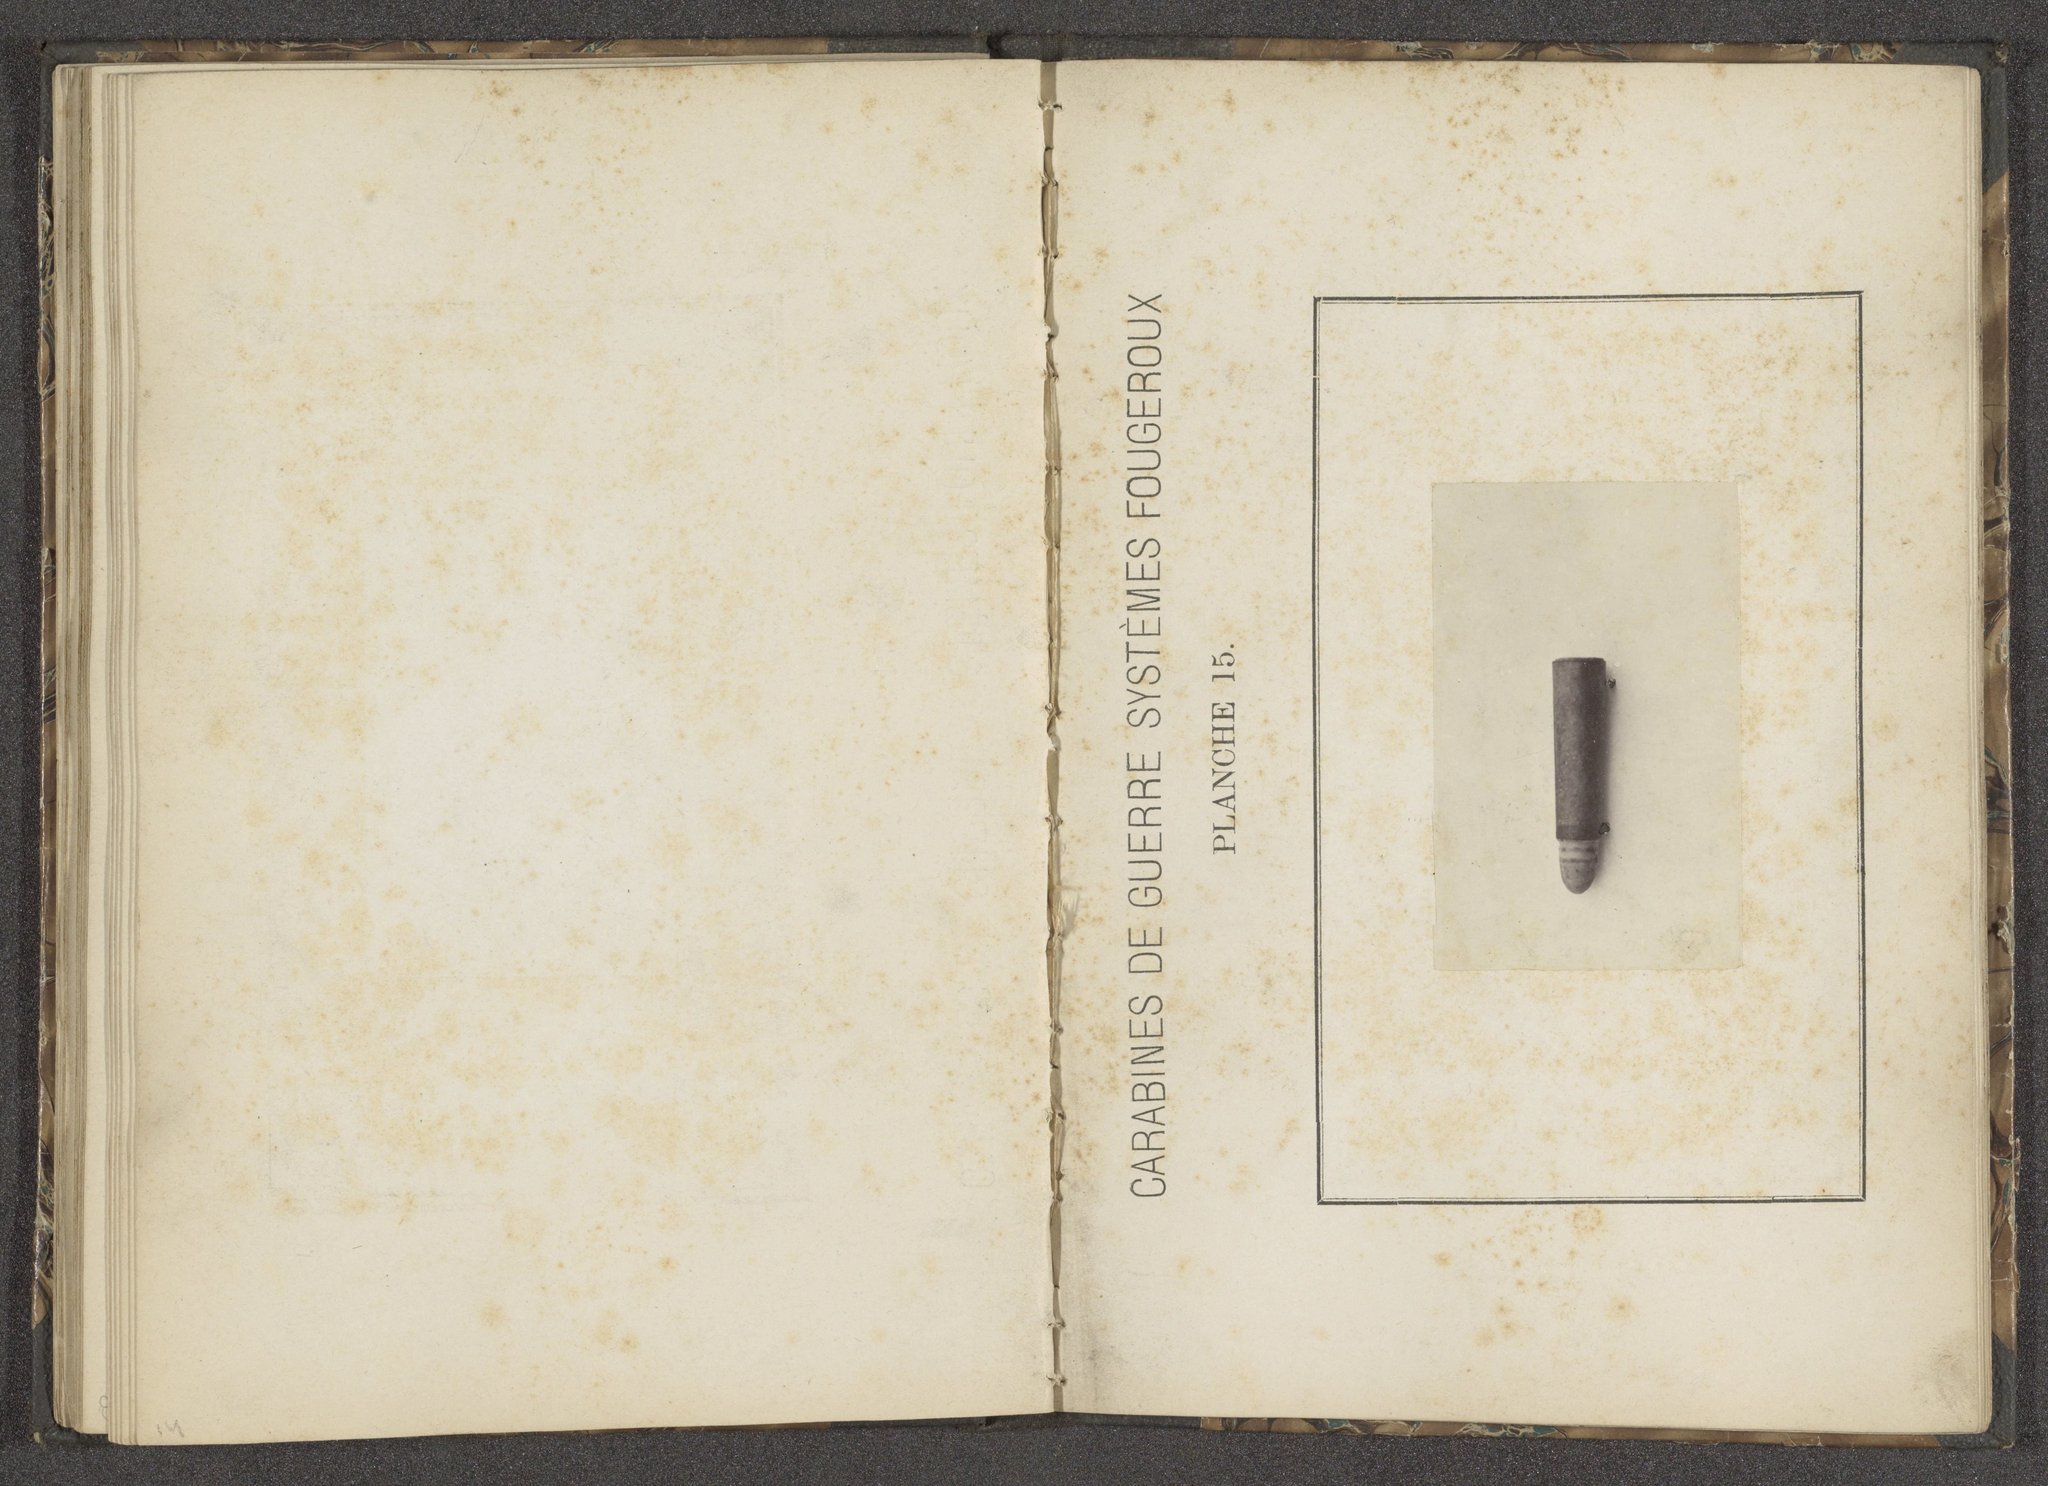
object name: page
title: Kogel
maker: edouard magis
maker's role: fotograaf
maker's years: 1828-1906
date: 1857-1867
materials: photographic support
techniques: albumen print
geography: liège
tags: ammunition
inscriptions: number: ‘Planche 15.’, inscription: ‘Carabines de guerres systèmes Fougeroux’